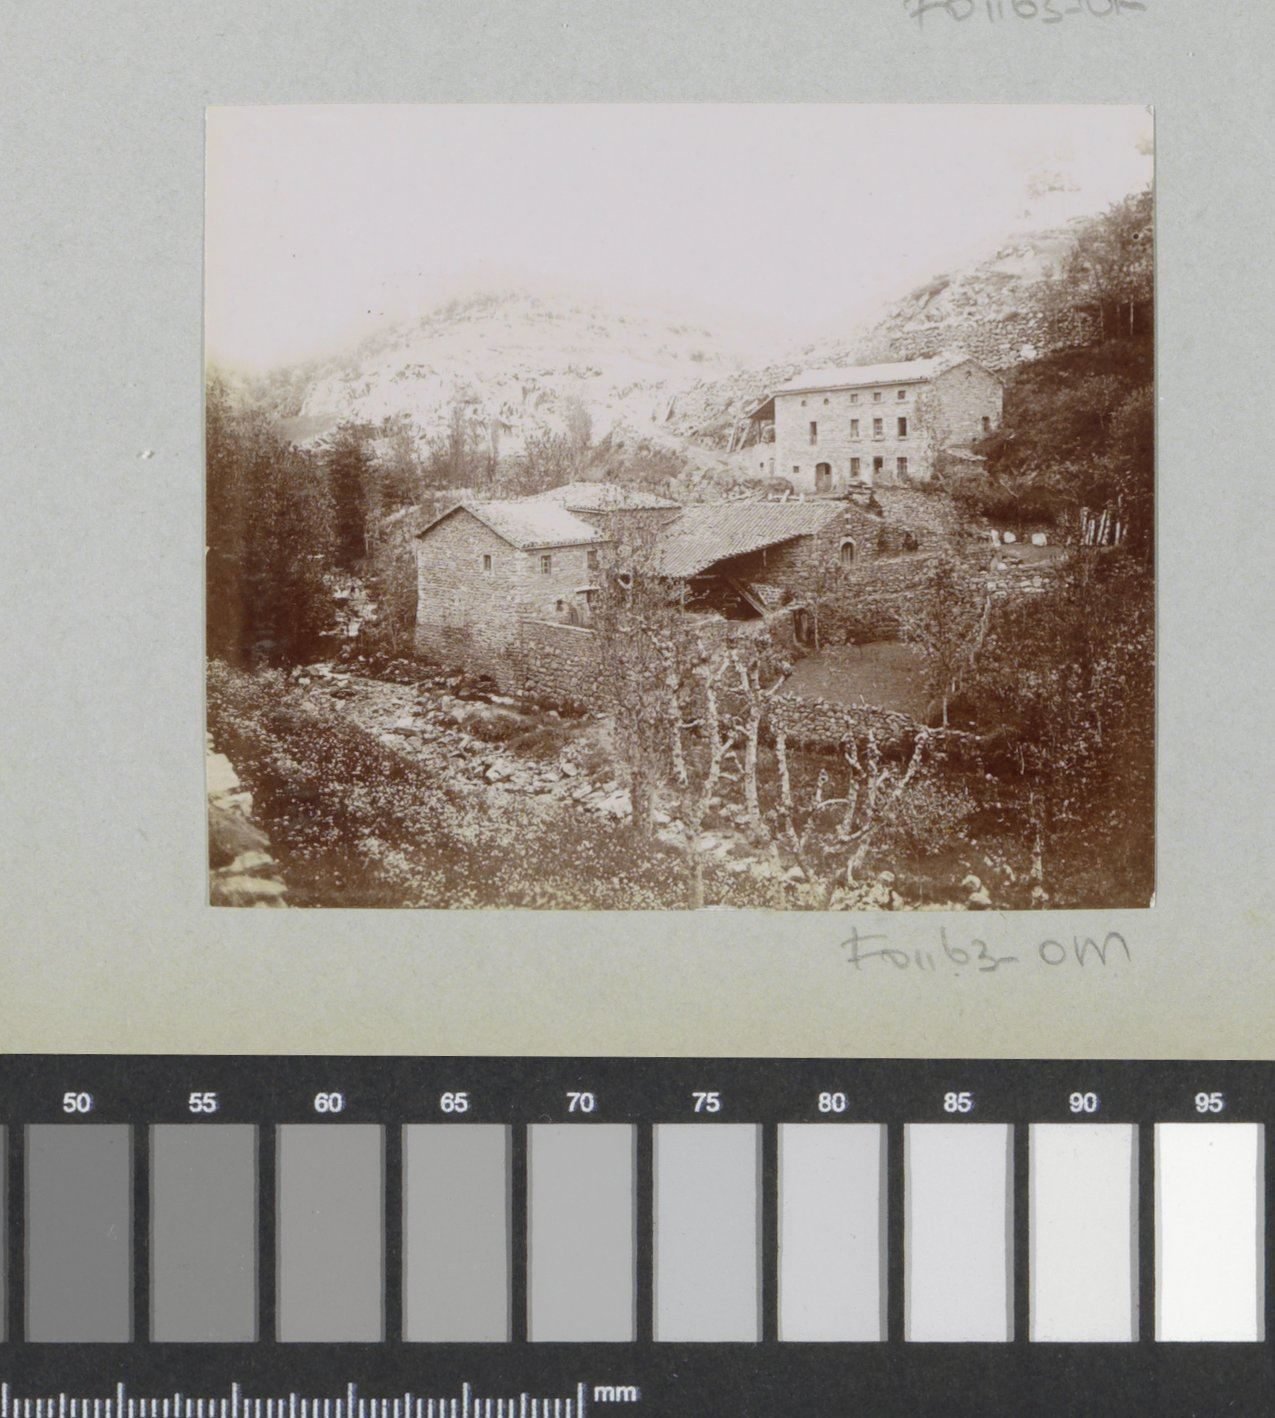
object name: photograph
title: Huizen tegen een bergwand, vermoedelijk in de Auvergne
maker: delizy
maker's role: manufacturer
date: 1902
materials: paper, photographic support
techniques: gelatin silver print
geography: auvergne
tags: prospect of village, silhouette of village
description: Onderdeel van Fotoalbum van een Franse amateurfotograaf met opnames van uitstapjes in Frankrijk, Spanje, België, Luxemburg en Nederland, de eerste automobielen en autoraces.